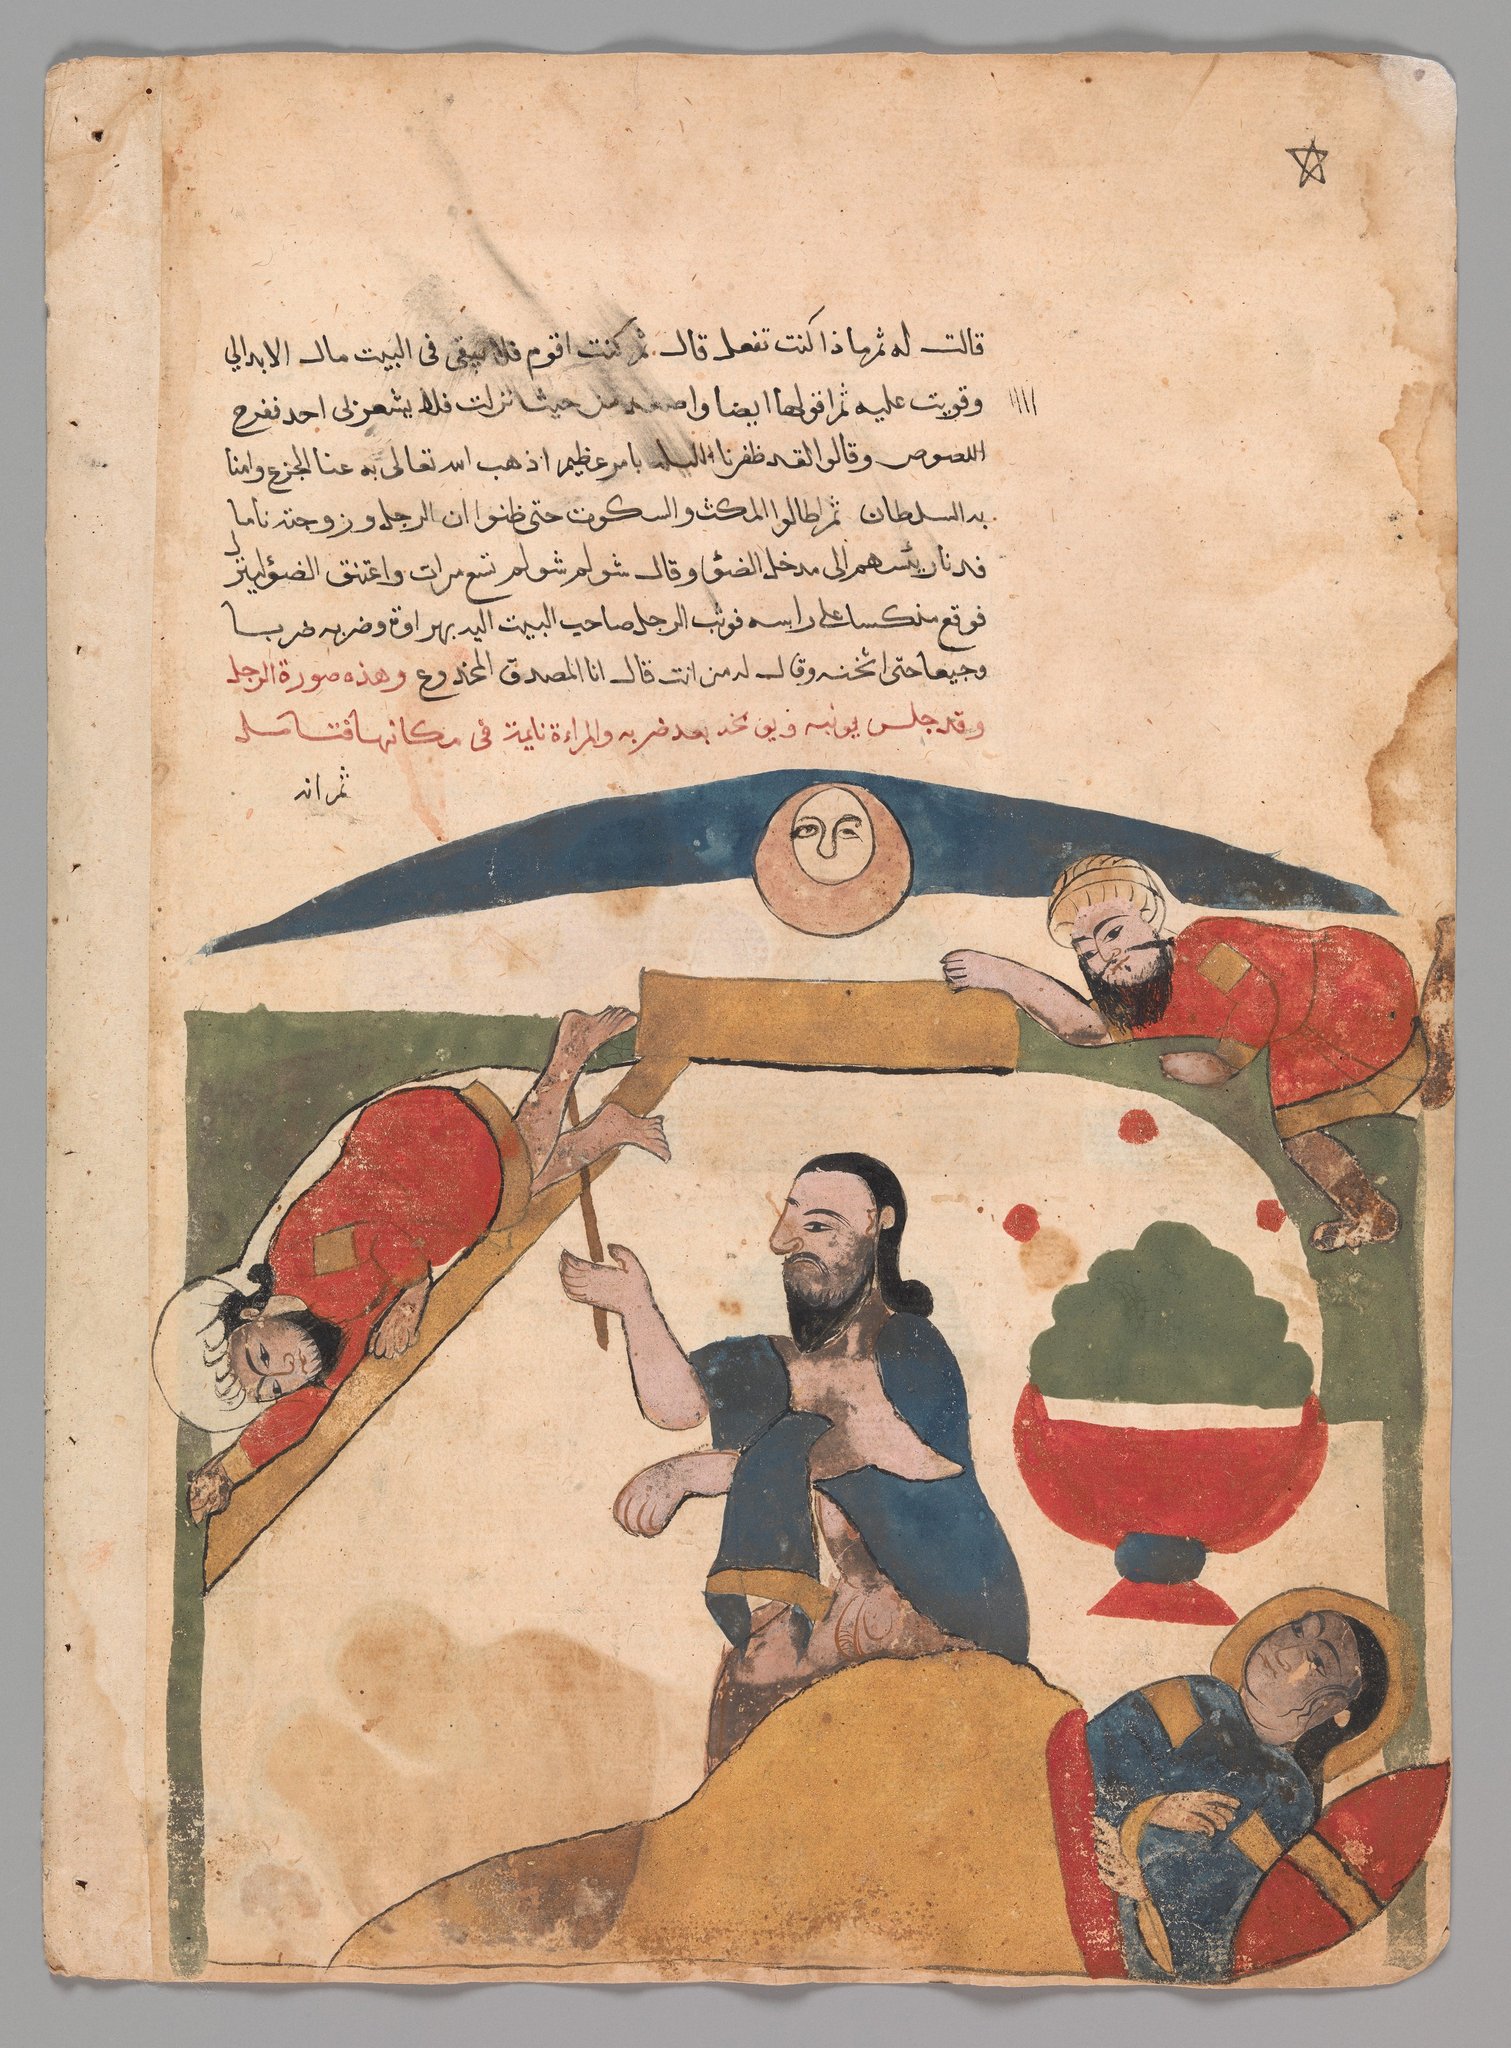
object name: folio from an illustrated manuscript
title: "The Thief Falls Through the Skylight in the Bedroom", Folio from a Kalila wa Dimna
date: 1526-1550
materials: ink, paper, watercolor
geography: india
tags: men,women